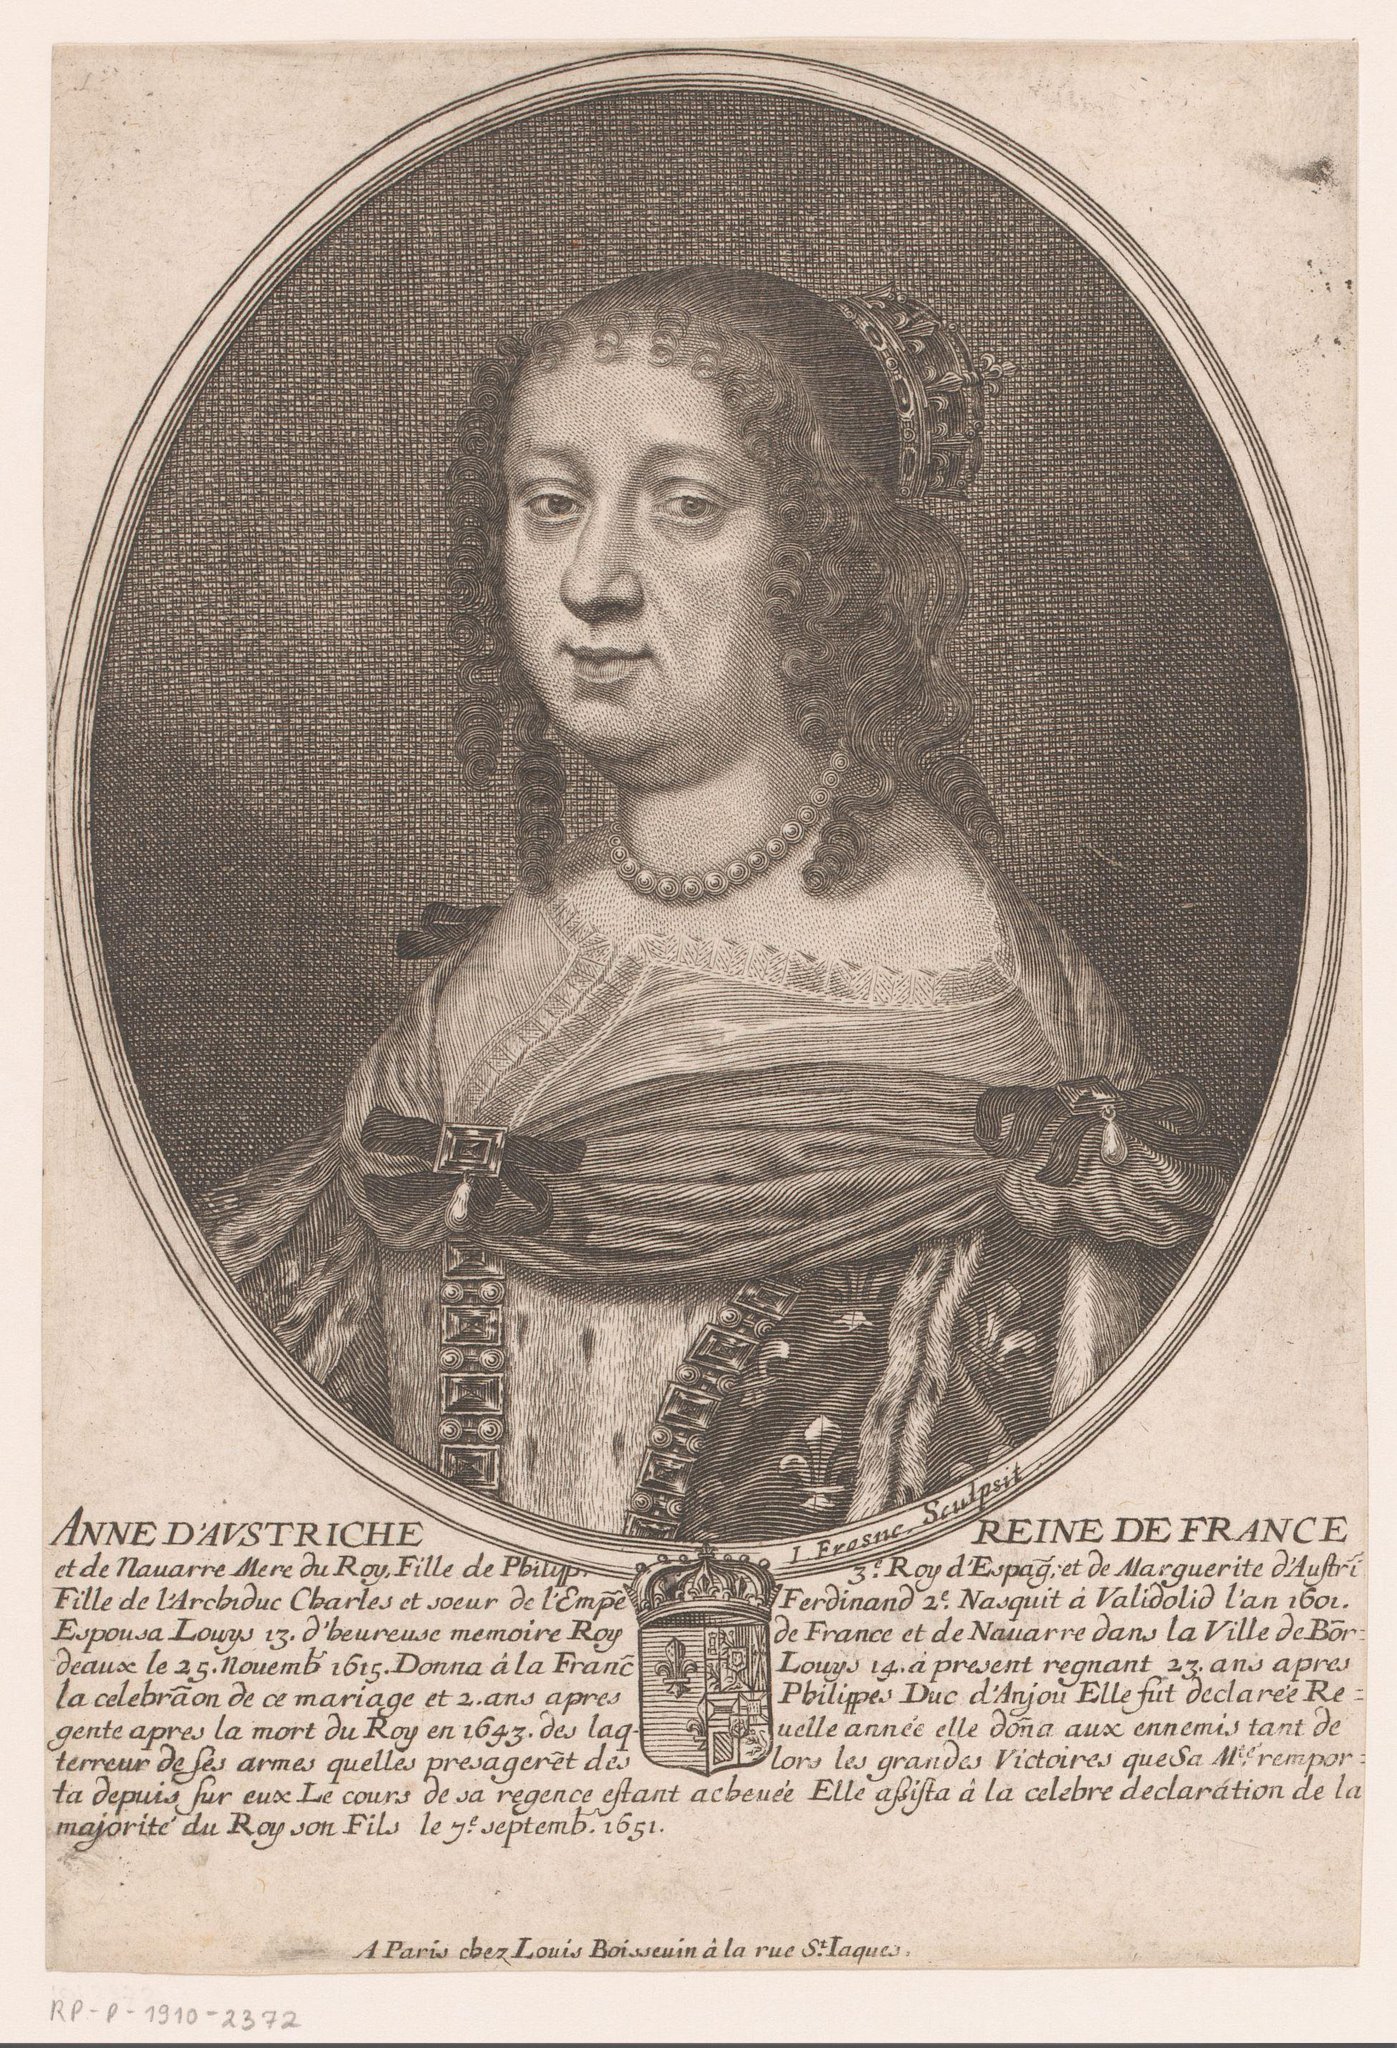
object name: print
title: Portret van Anna van Oostenrijk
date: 1633-1676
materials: paper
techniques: engraving, etching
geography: france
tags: anna van oostenrijk (koningin van frankrijk), historical persons - bb - woman, ornament ~ medallion, ruler, sovereign - bb - female ruler, armorial bearing, heraldry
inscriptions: collector's mark: Lugt 2228